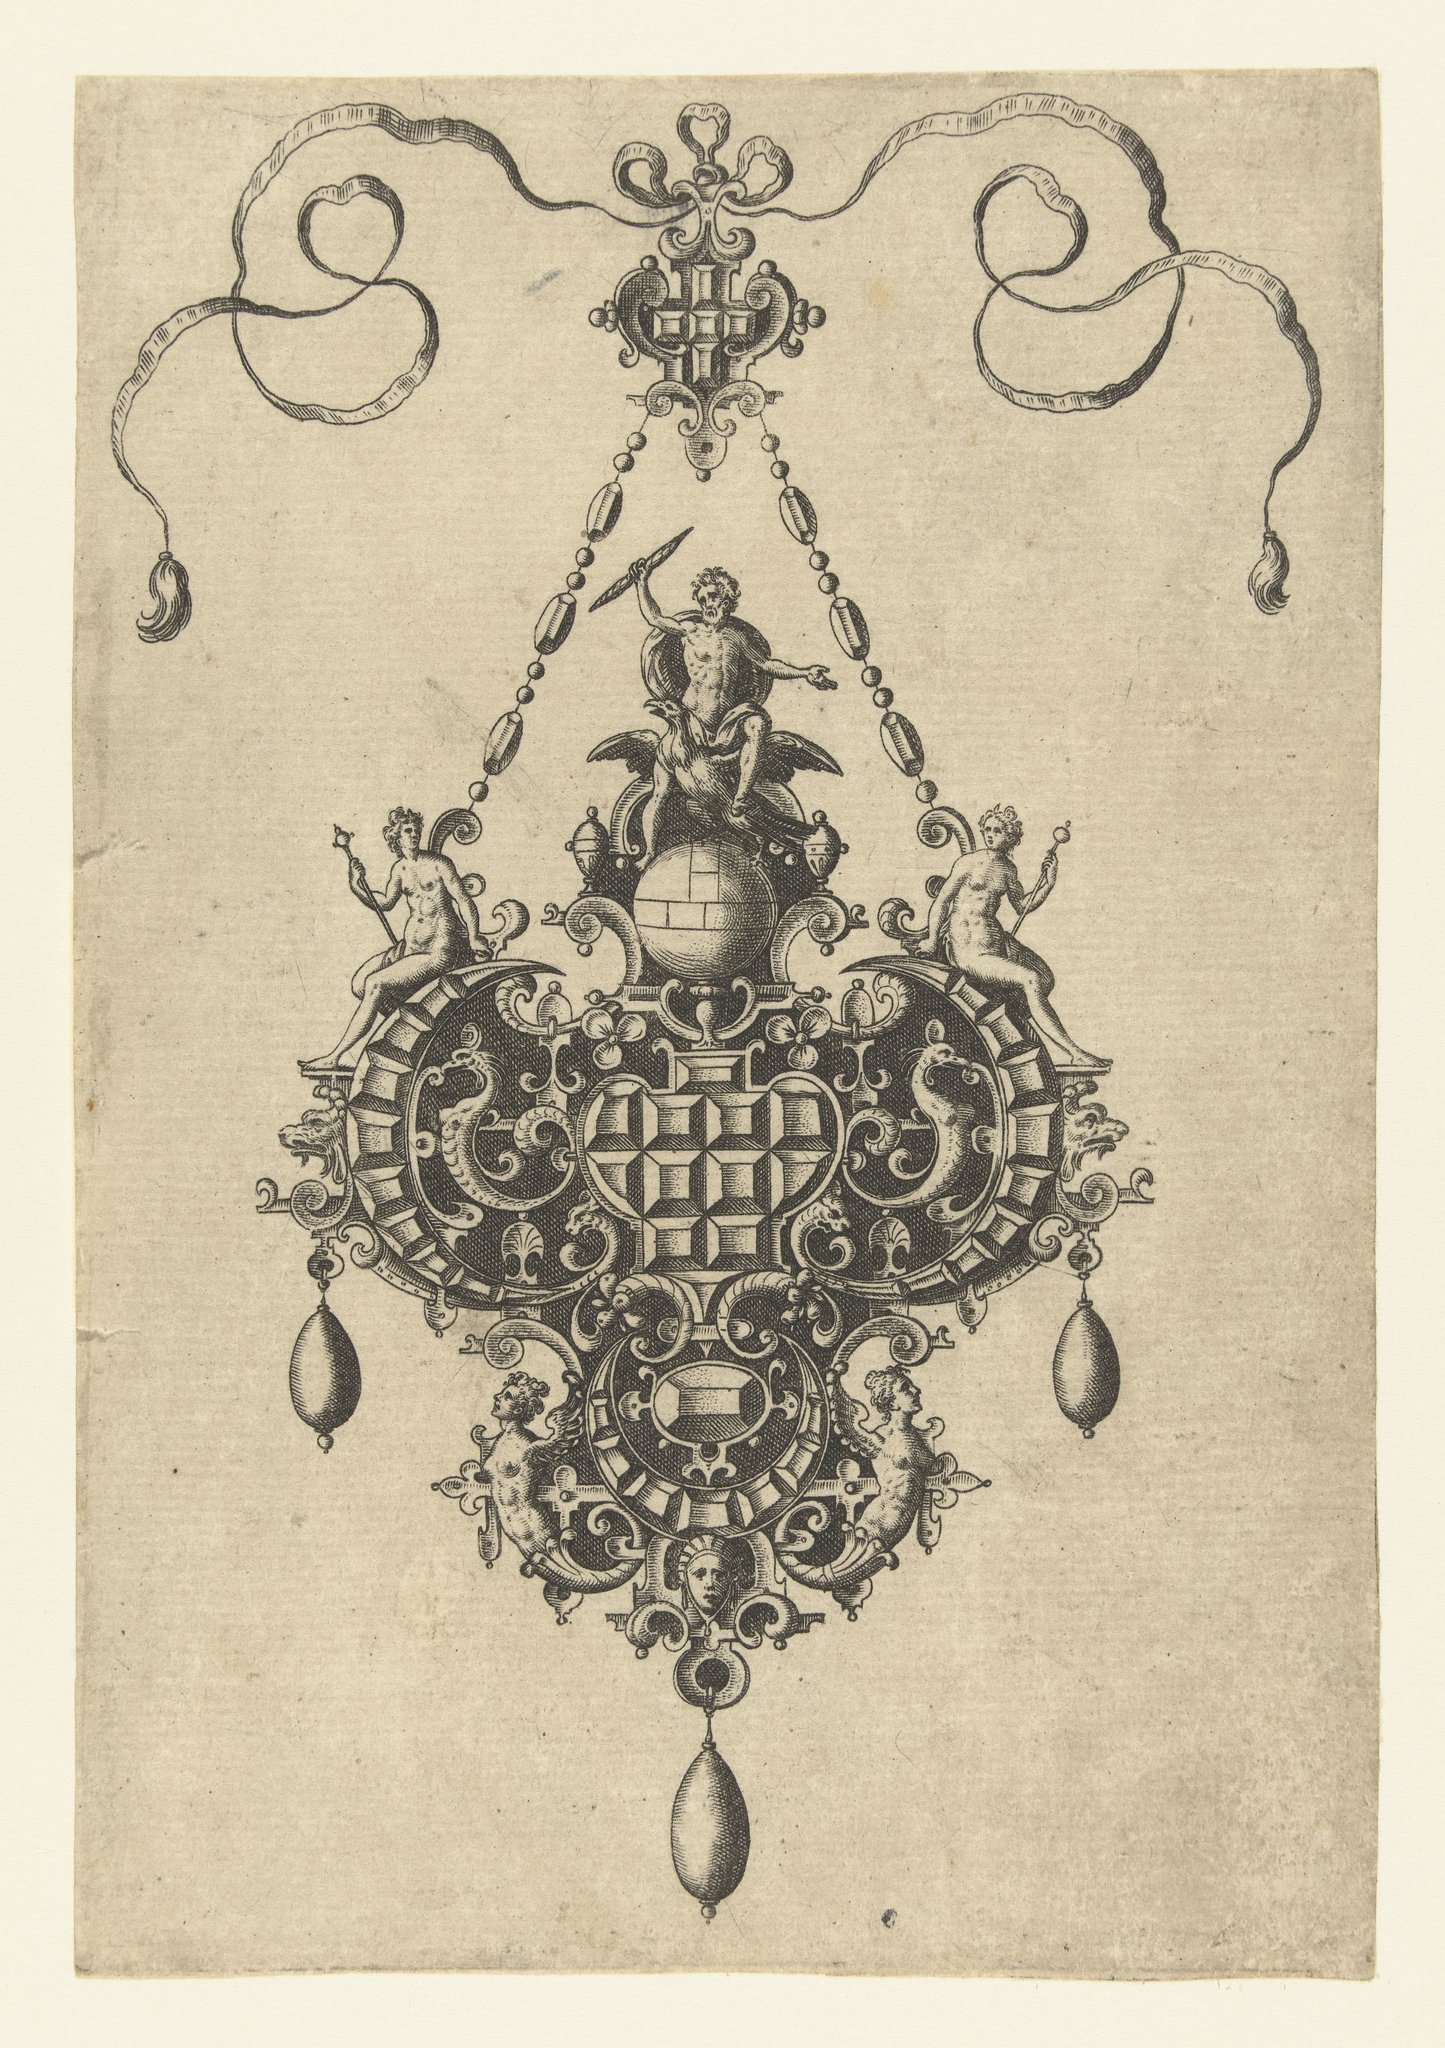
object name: print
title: Monilium bullarum inauriumque … icones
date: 1581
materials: paper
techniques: engraving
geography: netherlands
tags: pendant, trinket, 'breloque', attributes of jupiter: eagle, attributes of jupiter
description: Bovenop de hanger zit Zeus op zijn adelaar, een bliksemschicht in zijn hand. No. 5 uit serie van 10 bladen met voorzijden van hangers. Edelstenen in zettingen van grotesken en rolwerk.